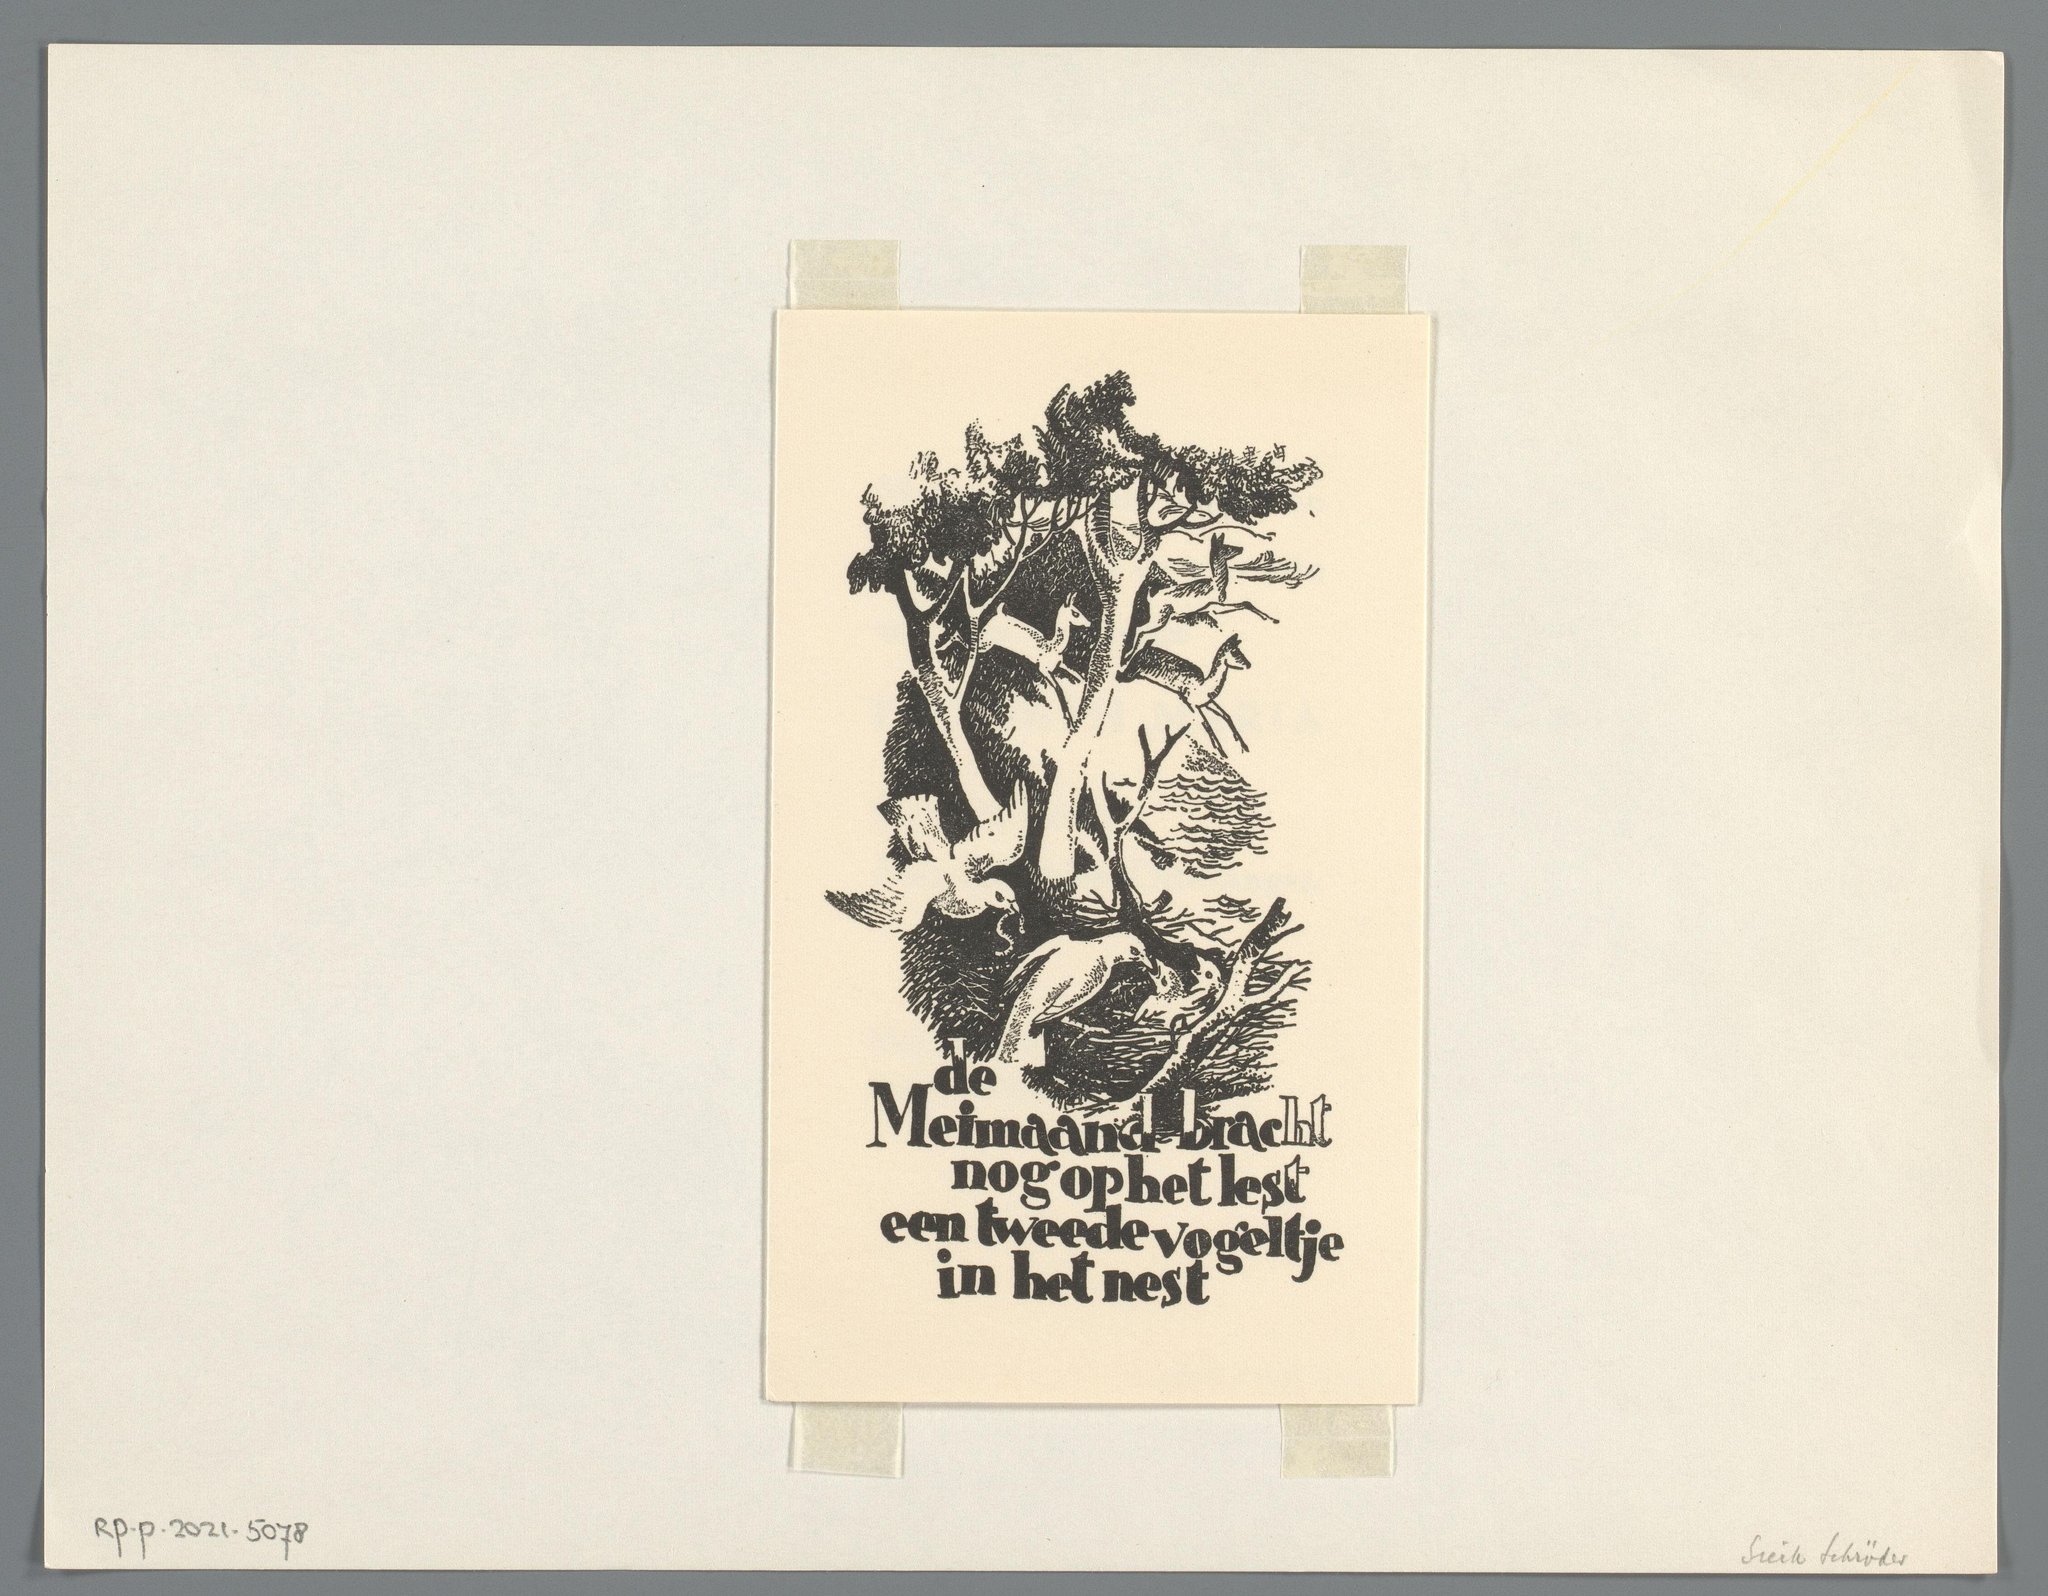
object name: birth announcement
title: Geboortekaart voor Liesbeth Maria Schröder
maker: Anonymous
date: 1937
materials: paper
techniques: printing block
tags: painter, print maker, sierk schröder, hoofed animals: deer, birds, announcement of birth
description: Op de voorzijde een vogelnest waar de ouders aan komen vliegen om de jongen te voeren. Op de achtergrond drie herten. Daaronder de tekst: 'De Meimaand bracht nog op het lest een tweede vogeltje in het nest'. Binnenin de tekst: 'Met groote blijdschap geven wij kennis van de geboorte van ons dochtertje Liesbeth Maria. Sierk Schröder. Mies Schröder-Ottevanger. Den Haag, 24 mei 1937. Sneeuwklokjesstraat 20'.